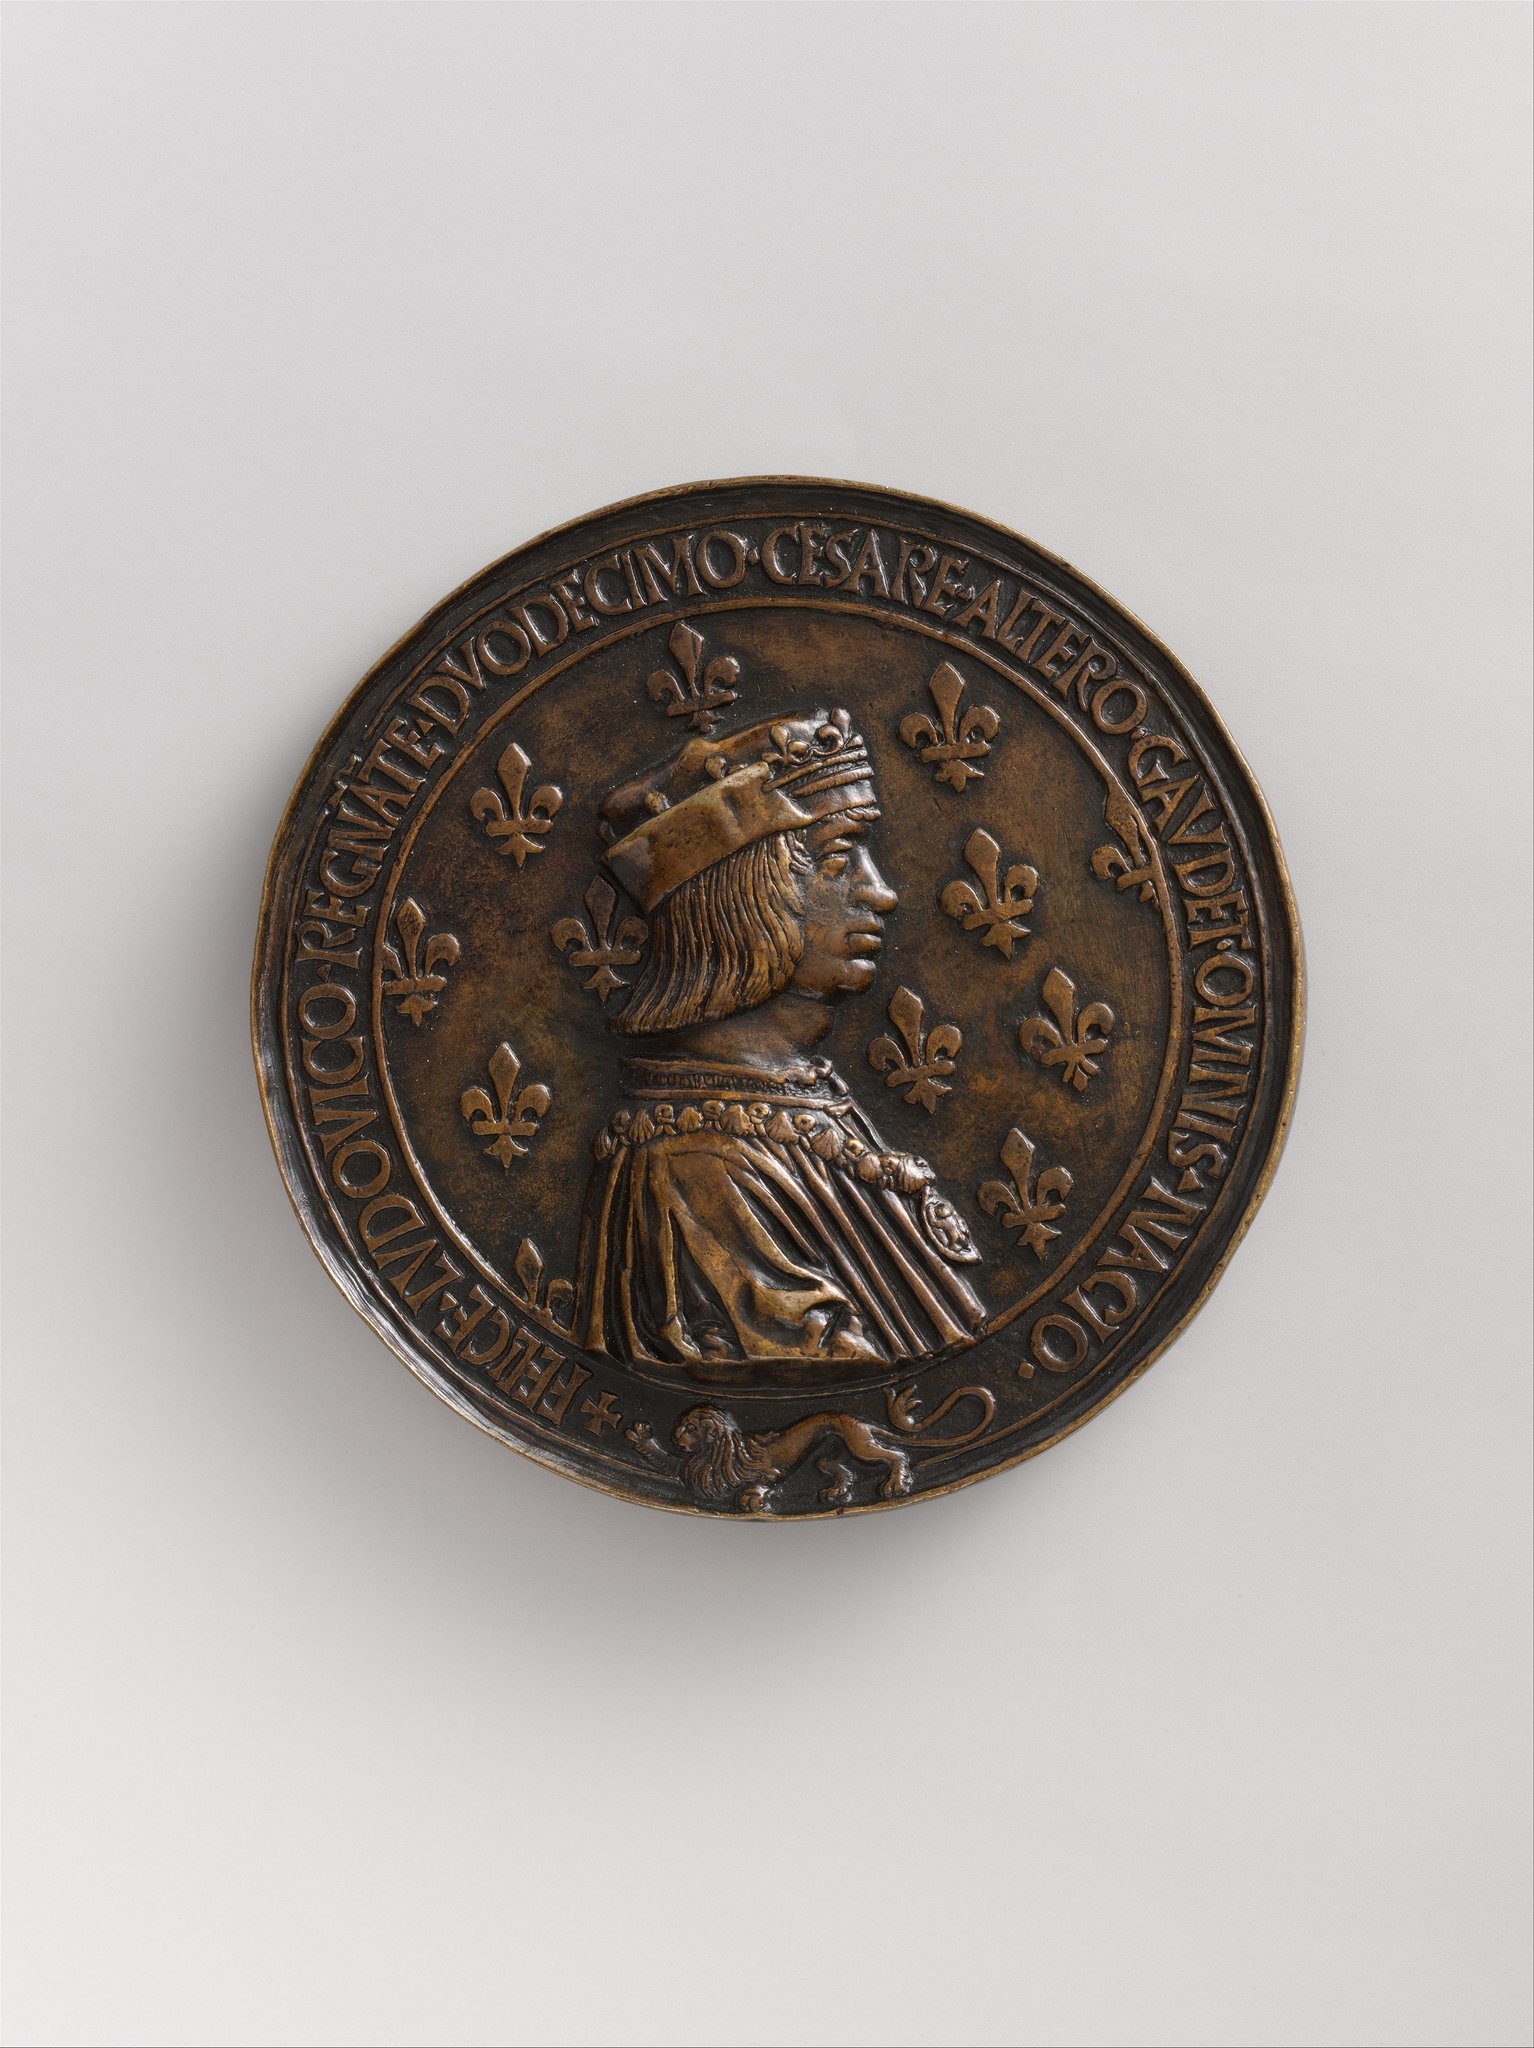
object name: medal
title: Medal Louis XII, King of France (r. 1498–15155), and Anne of Brittany (1476–1514)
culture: french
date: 1499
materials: copper alloy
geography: france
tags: kings,queens,lions